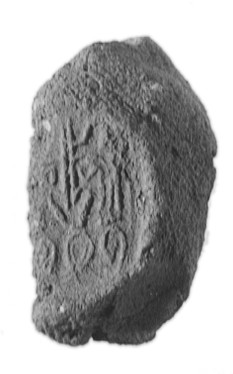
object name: sealing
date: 2030-1640 BCE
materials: clay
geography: egypt